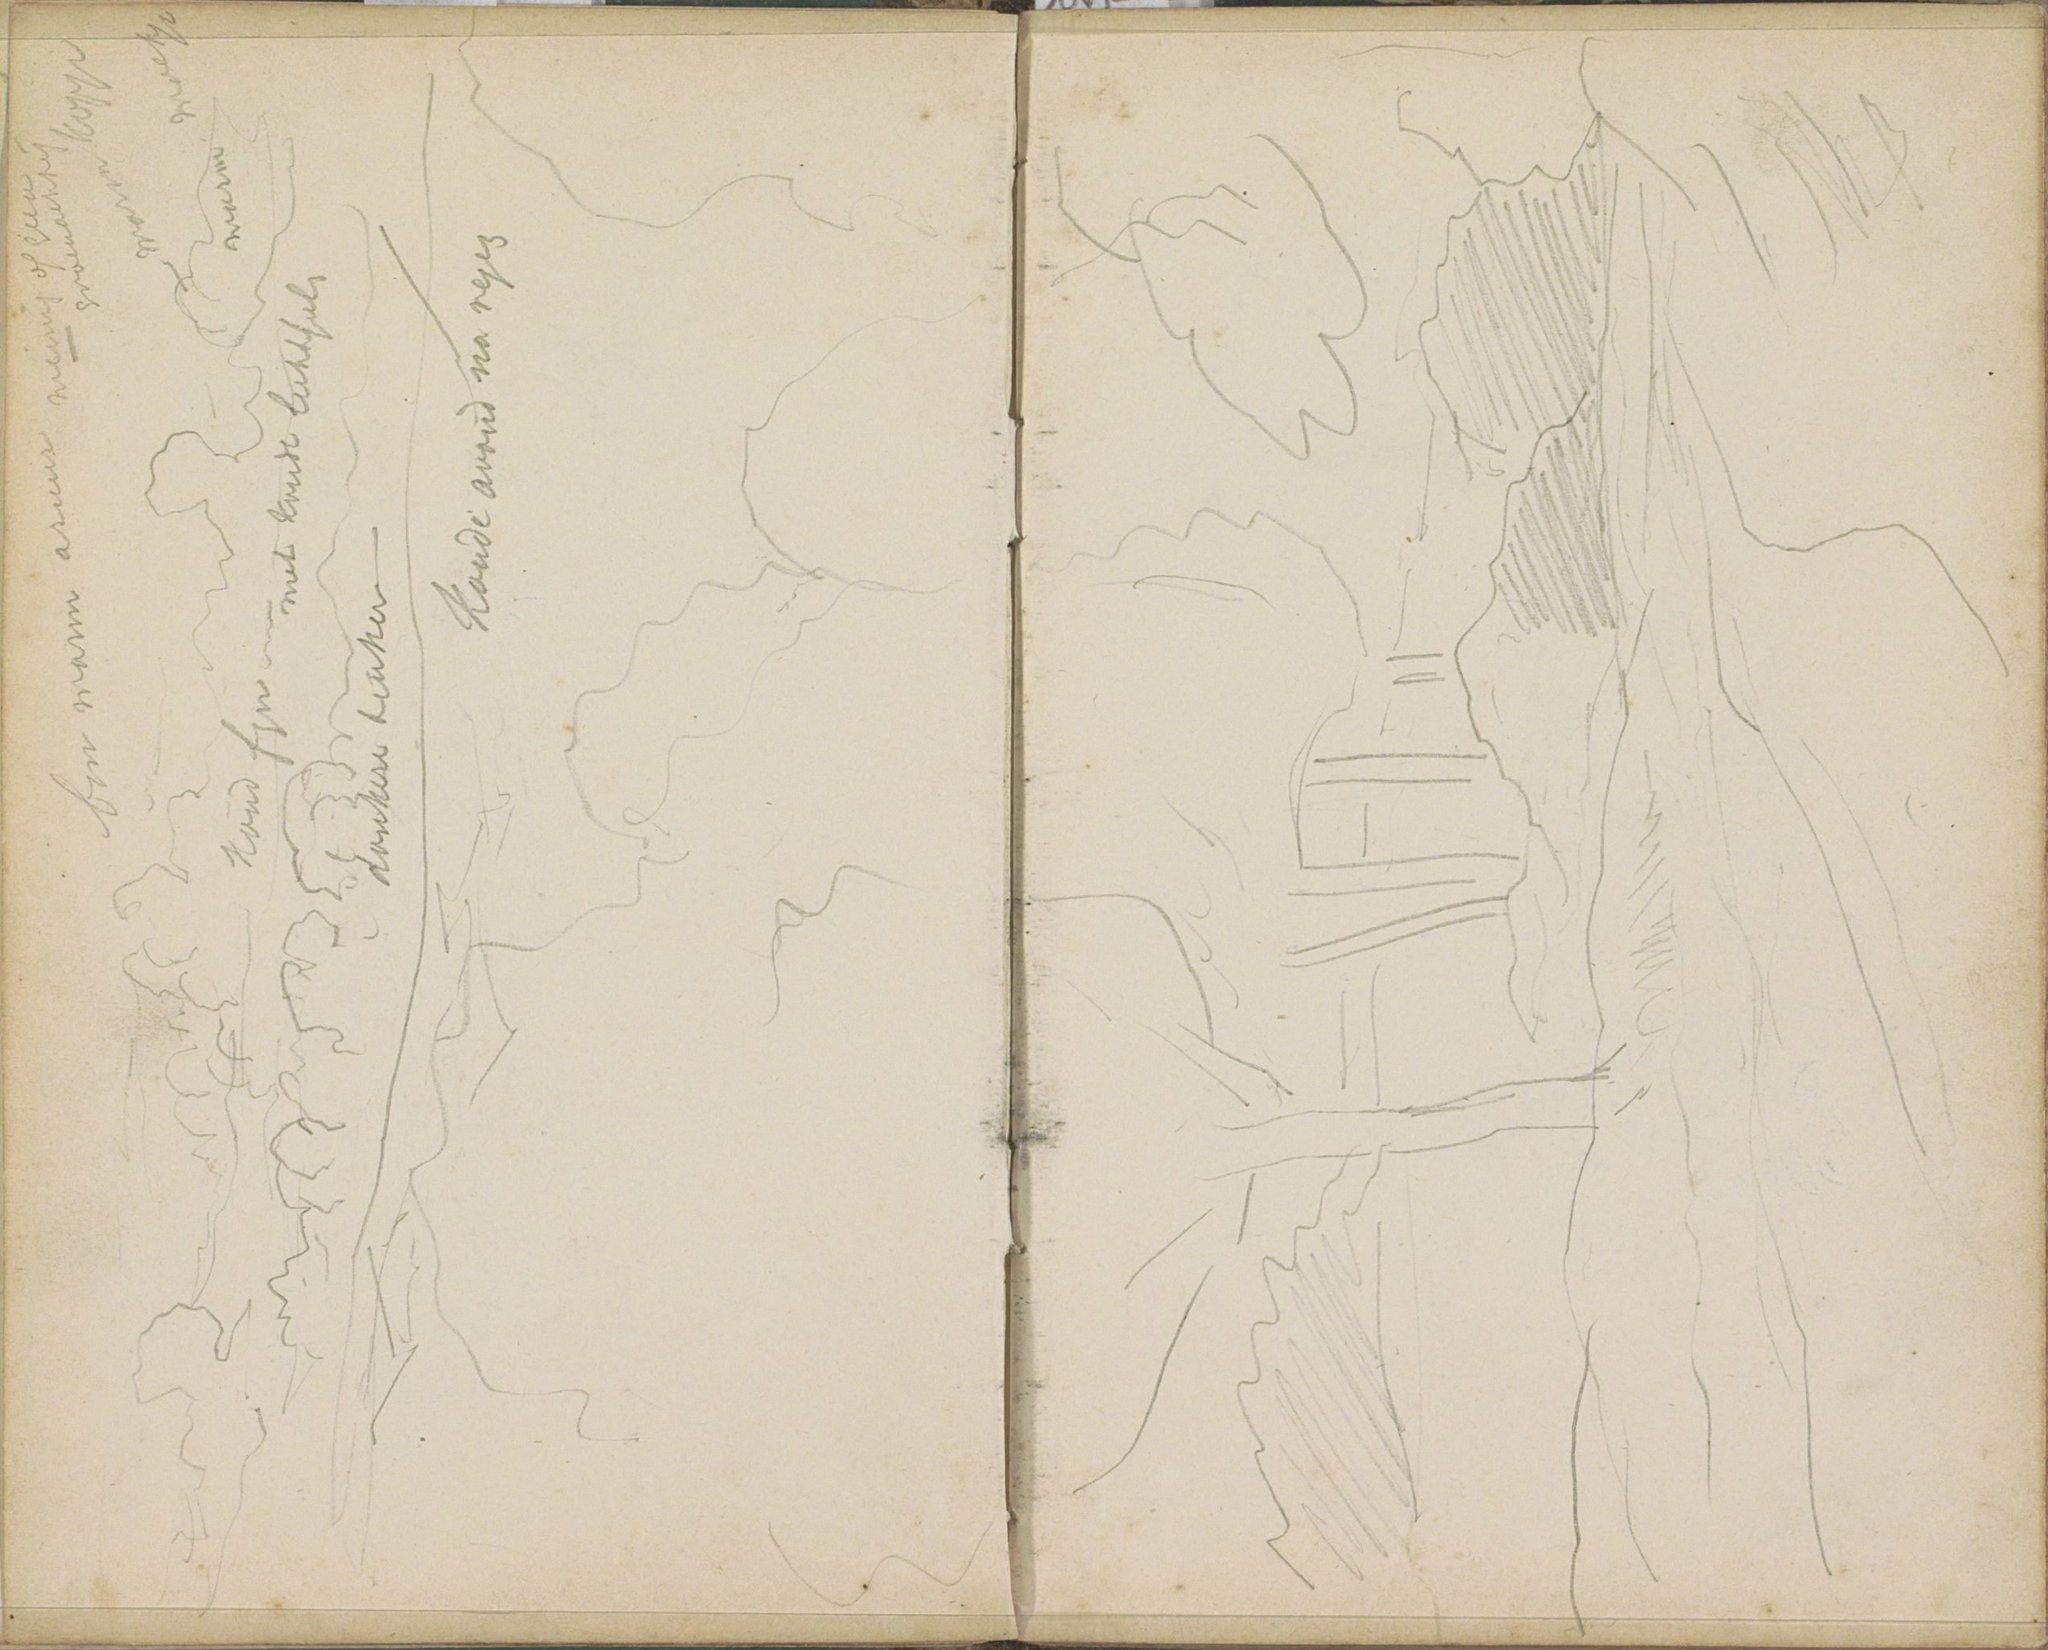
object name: sketchbook leaf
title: Landschap met bomen langs een landweg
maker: johannes tavenraat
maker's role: draughtsman, painter, print maker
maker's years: 1809-1881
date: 1839-1872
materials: paper, pencil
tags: trees, landscapes, road, path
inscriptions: kleurnotitie, handgeschreven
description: Blad 16 verso en 17 recto uit een schetsboek met 73 bladen.